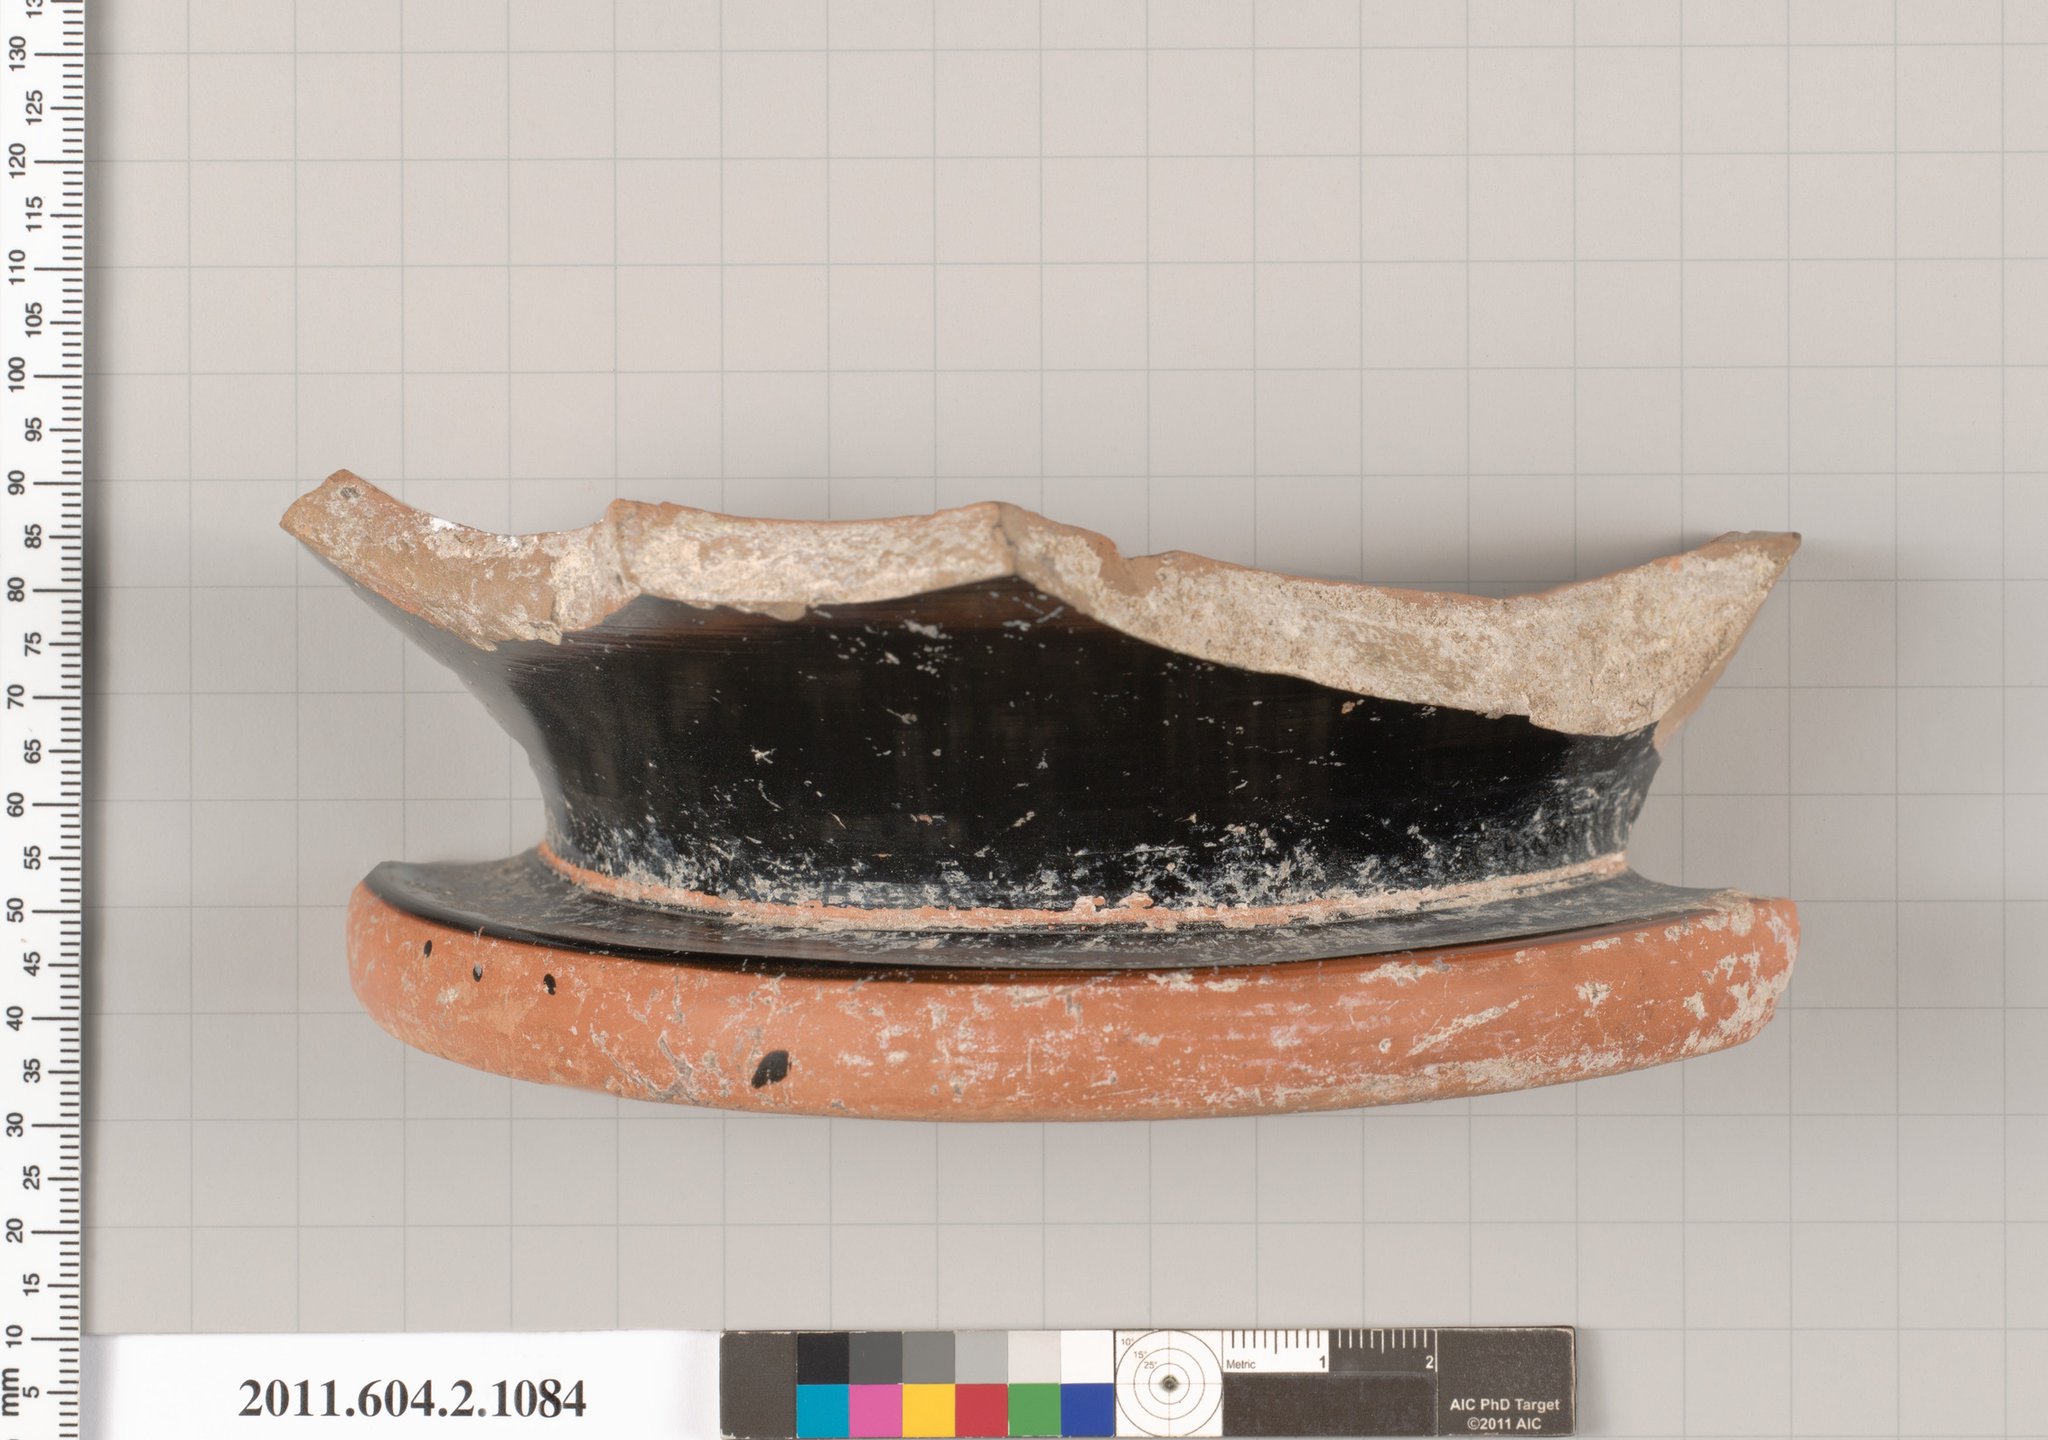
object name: pelike fragment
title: Terracotta fragment of a pelike (jar)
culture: greek, attic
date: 534-468 BCE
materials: terracotta